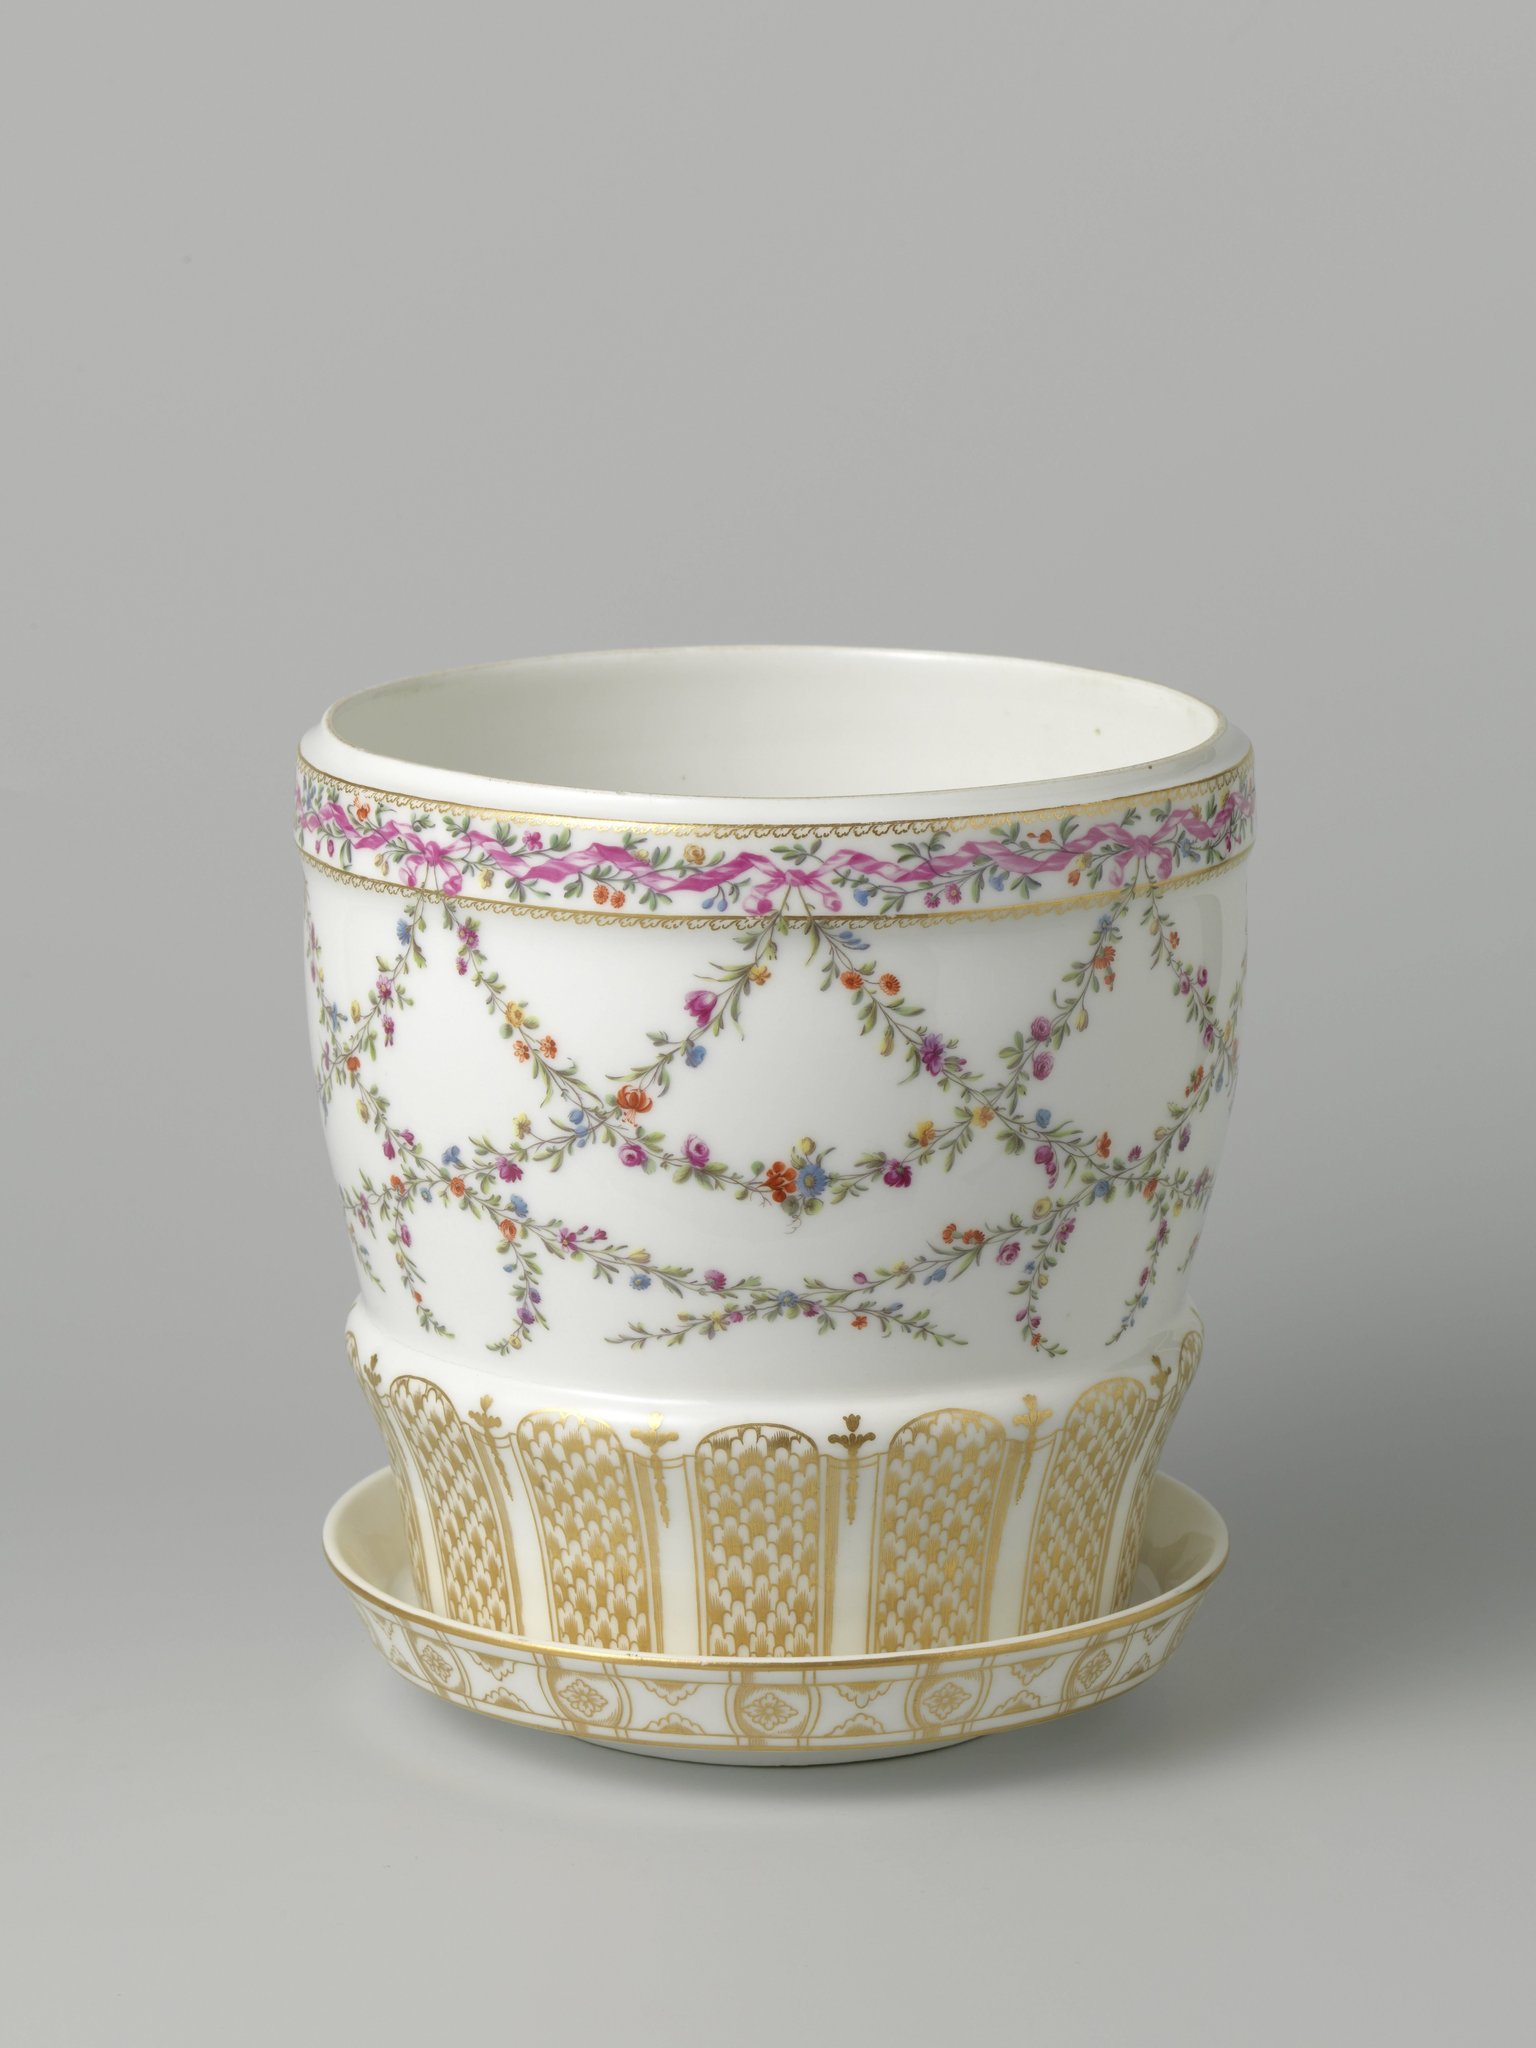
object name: wine cooler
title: Two wine coolers and stands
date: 1778-1782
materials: porcelain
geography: loosdrecht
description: Manufactuur Oud-Loosdrecht Loosdrecht, c. 1778–1782 hard-paste porcelain